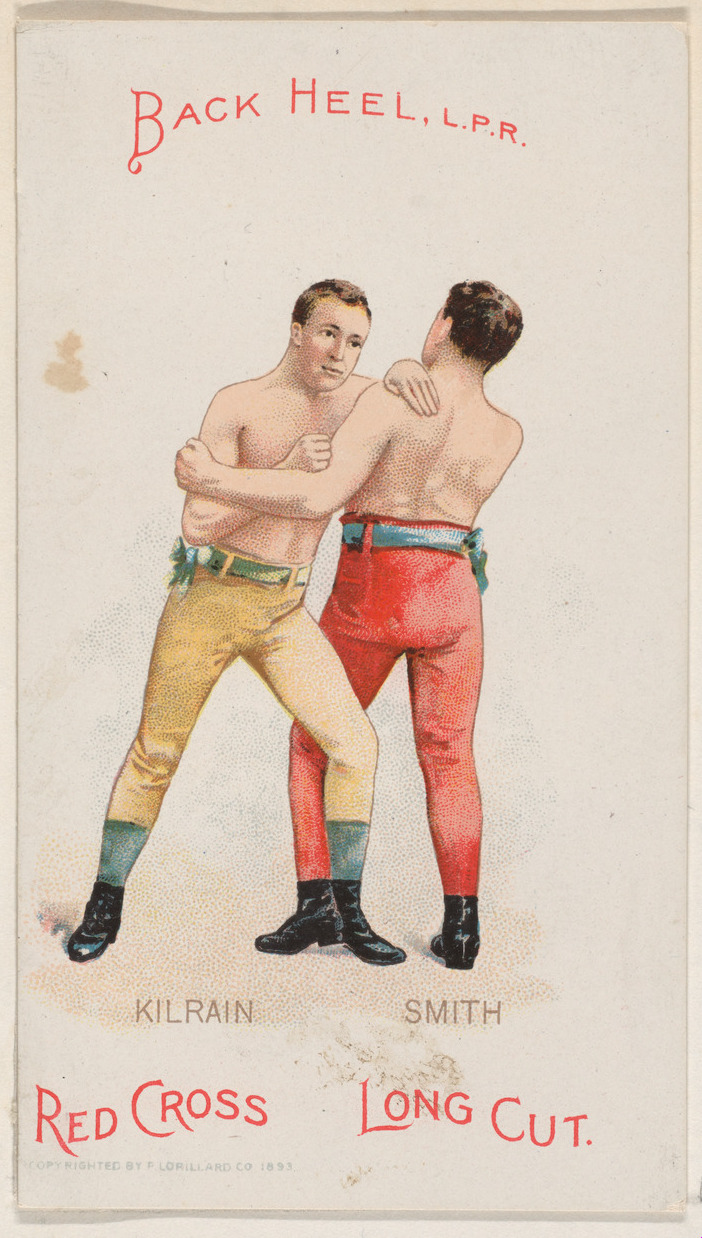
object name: print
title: Back Heel, L.P.R., Jake Kilrain and Jem Smith, from the Boxing Positions and Boxers series (N266) issued by P. Lorillard Company to promote Red Cross Long Cut Tobacco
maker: p. lorillard company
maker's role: publisher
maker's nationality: american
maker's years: 1760-2014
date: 1893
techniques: color lithograph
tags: men,boxing,athletes